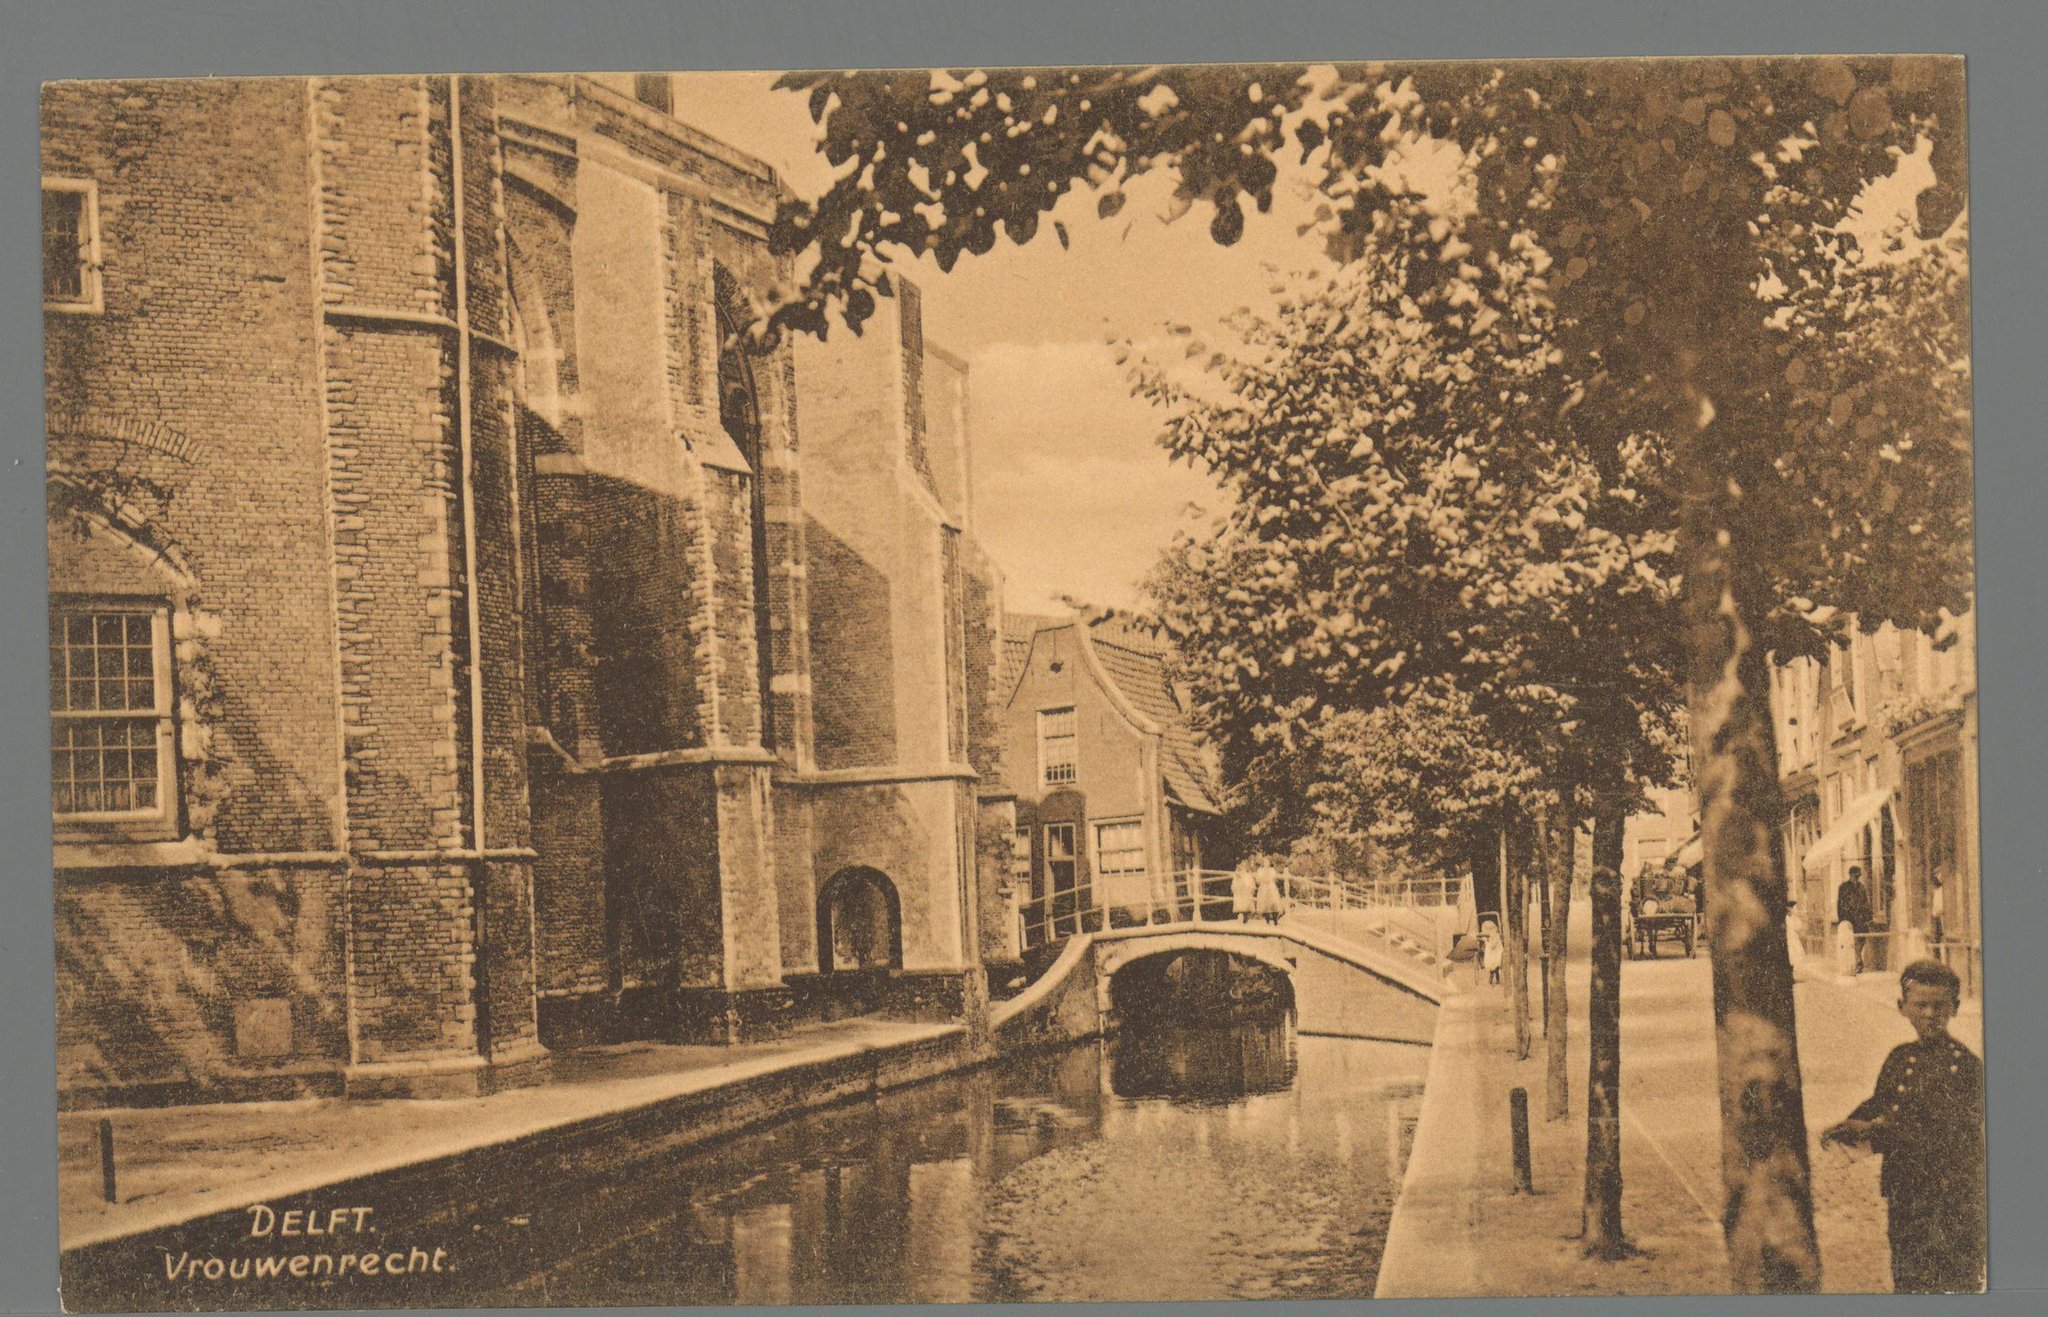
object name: photomechanical print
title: Delft. Vrouwenrecht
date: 1911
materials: cardboard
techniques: photograph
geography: delft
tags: city-view, and landscape with man-made constructions, canals, waters (in city), bridge in city across river, canal, etc.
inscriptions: date